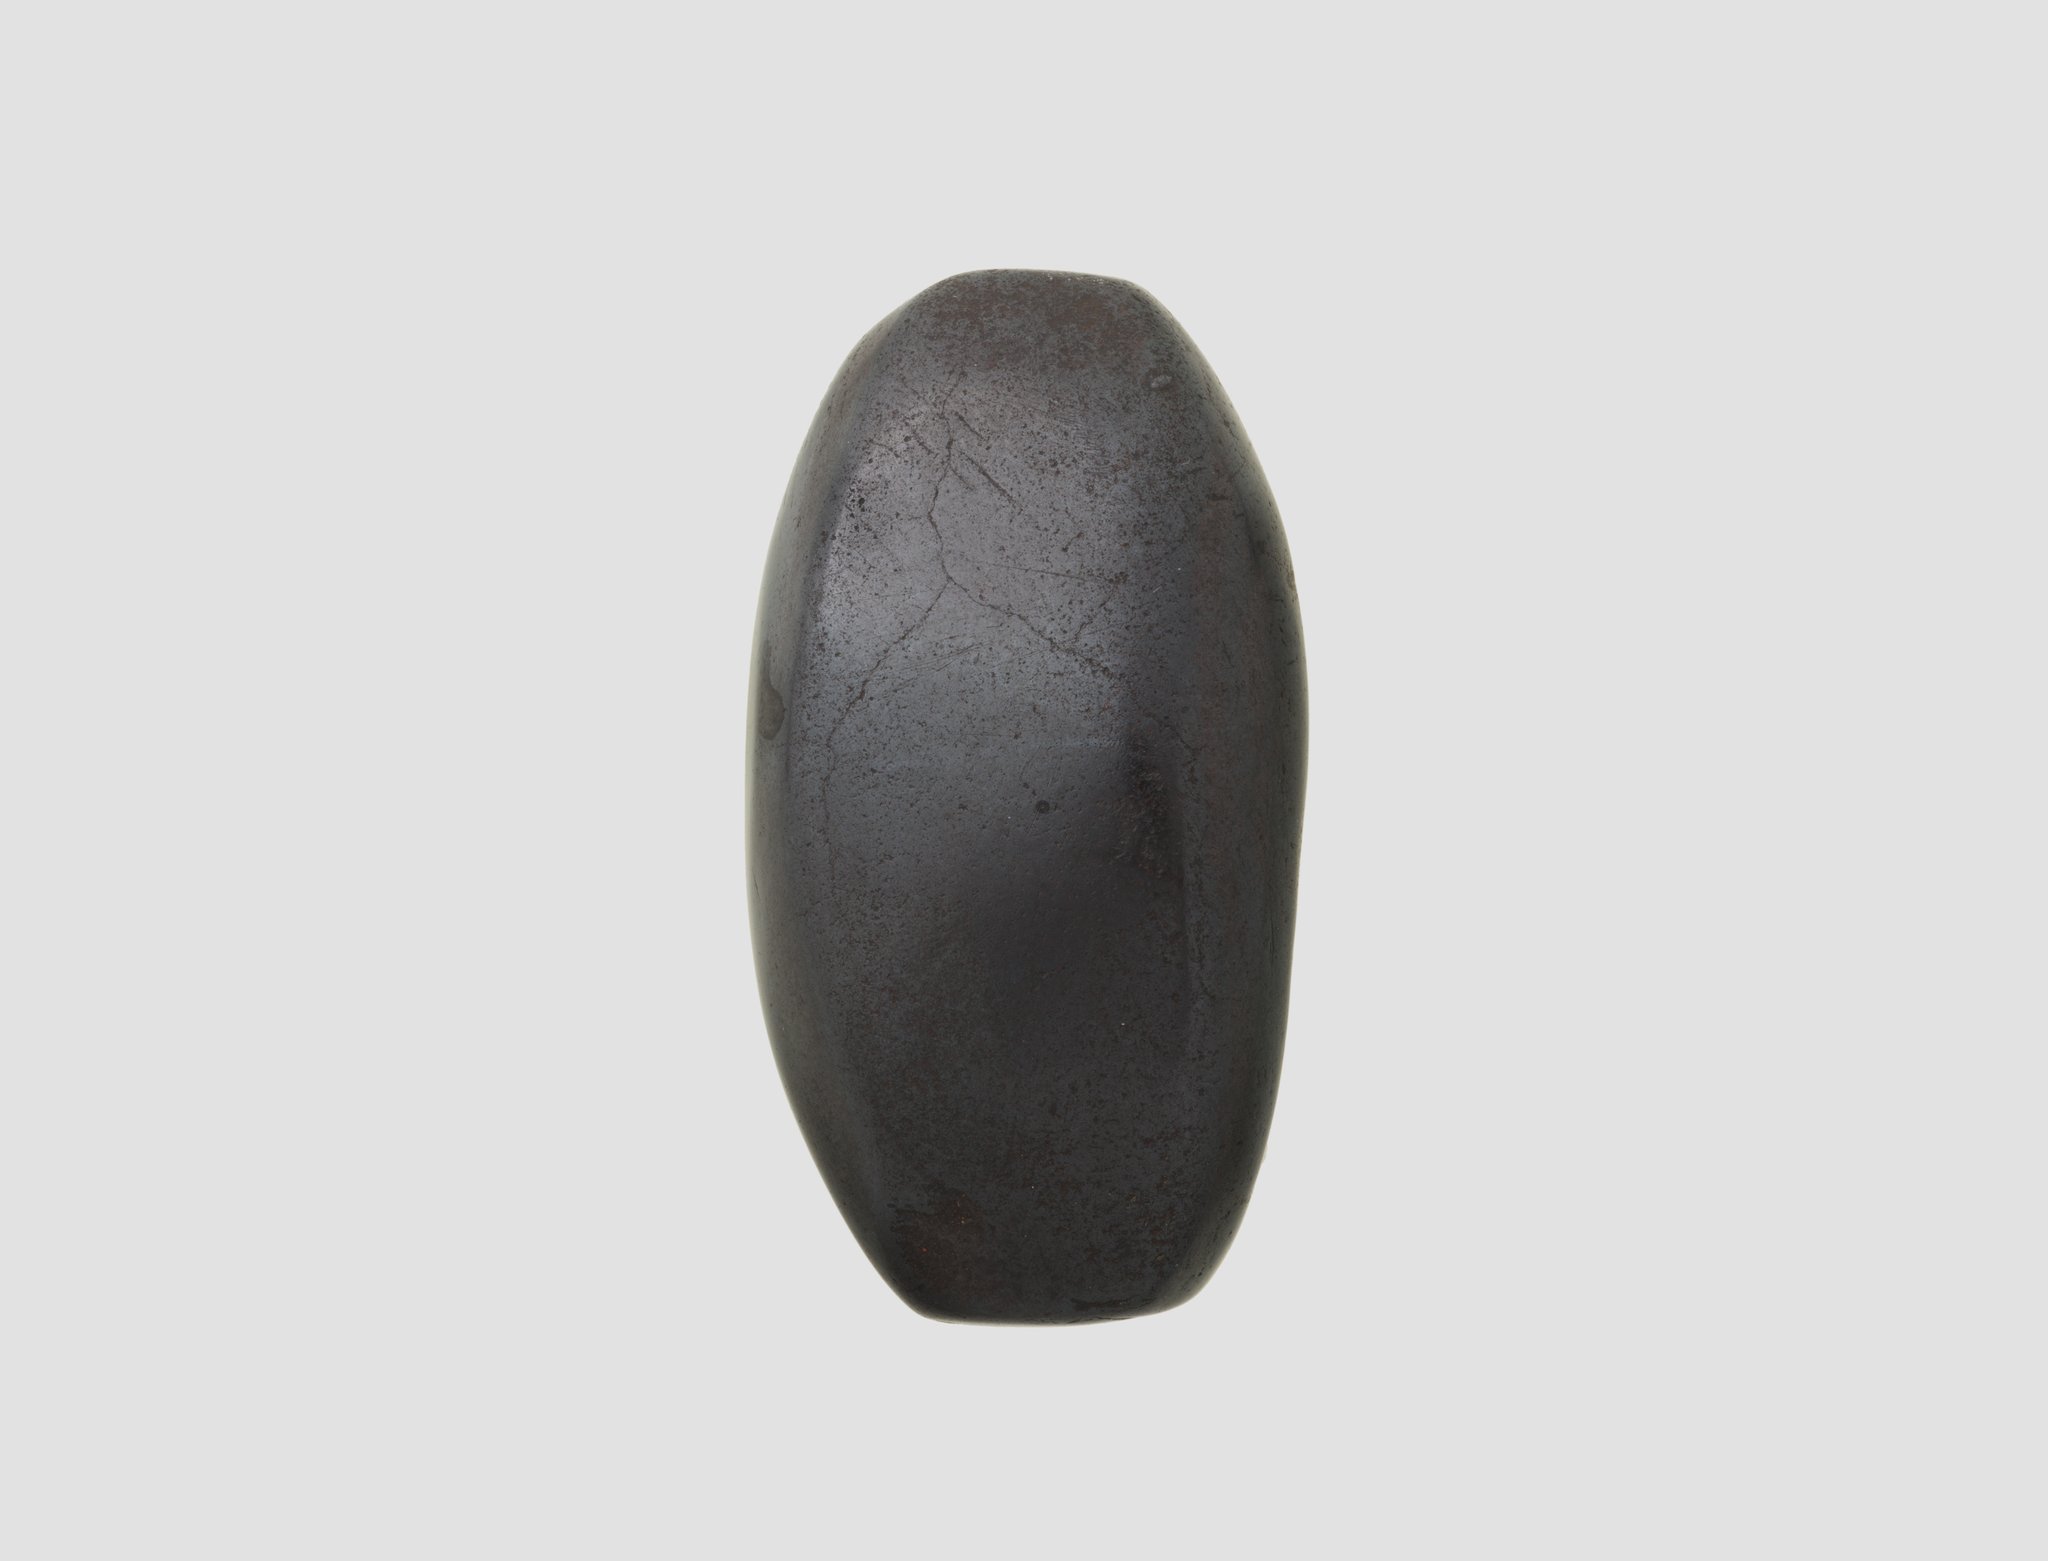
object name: weight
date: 3000-1 BCE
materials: mineral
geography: cyprus